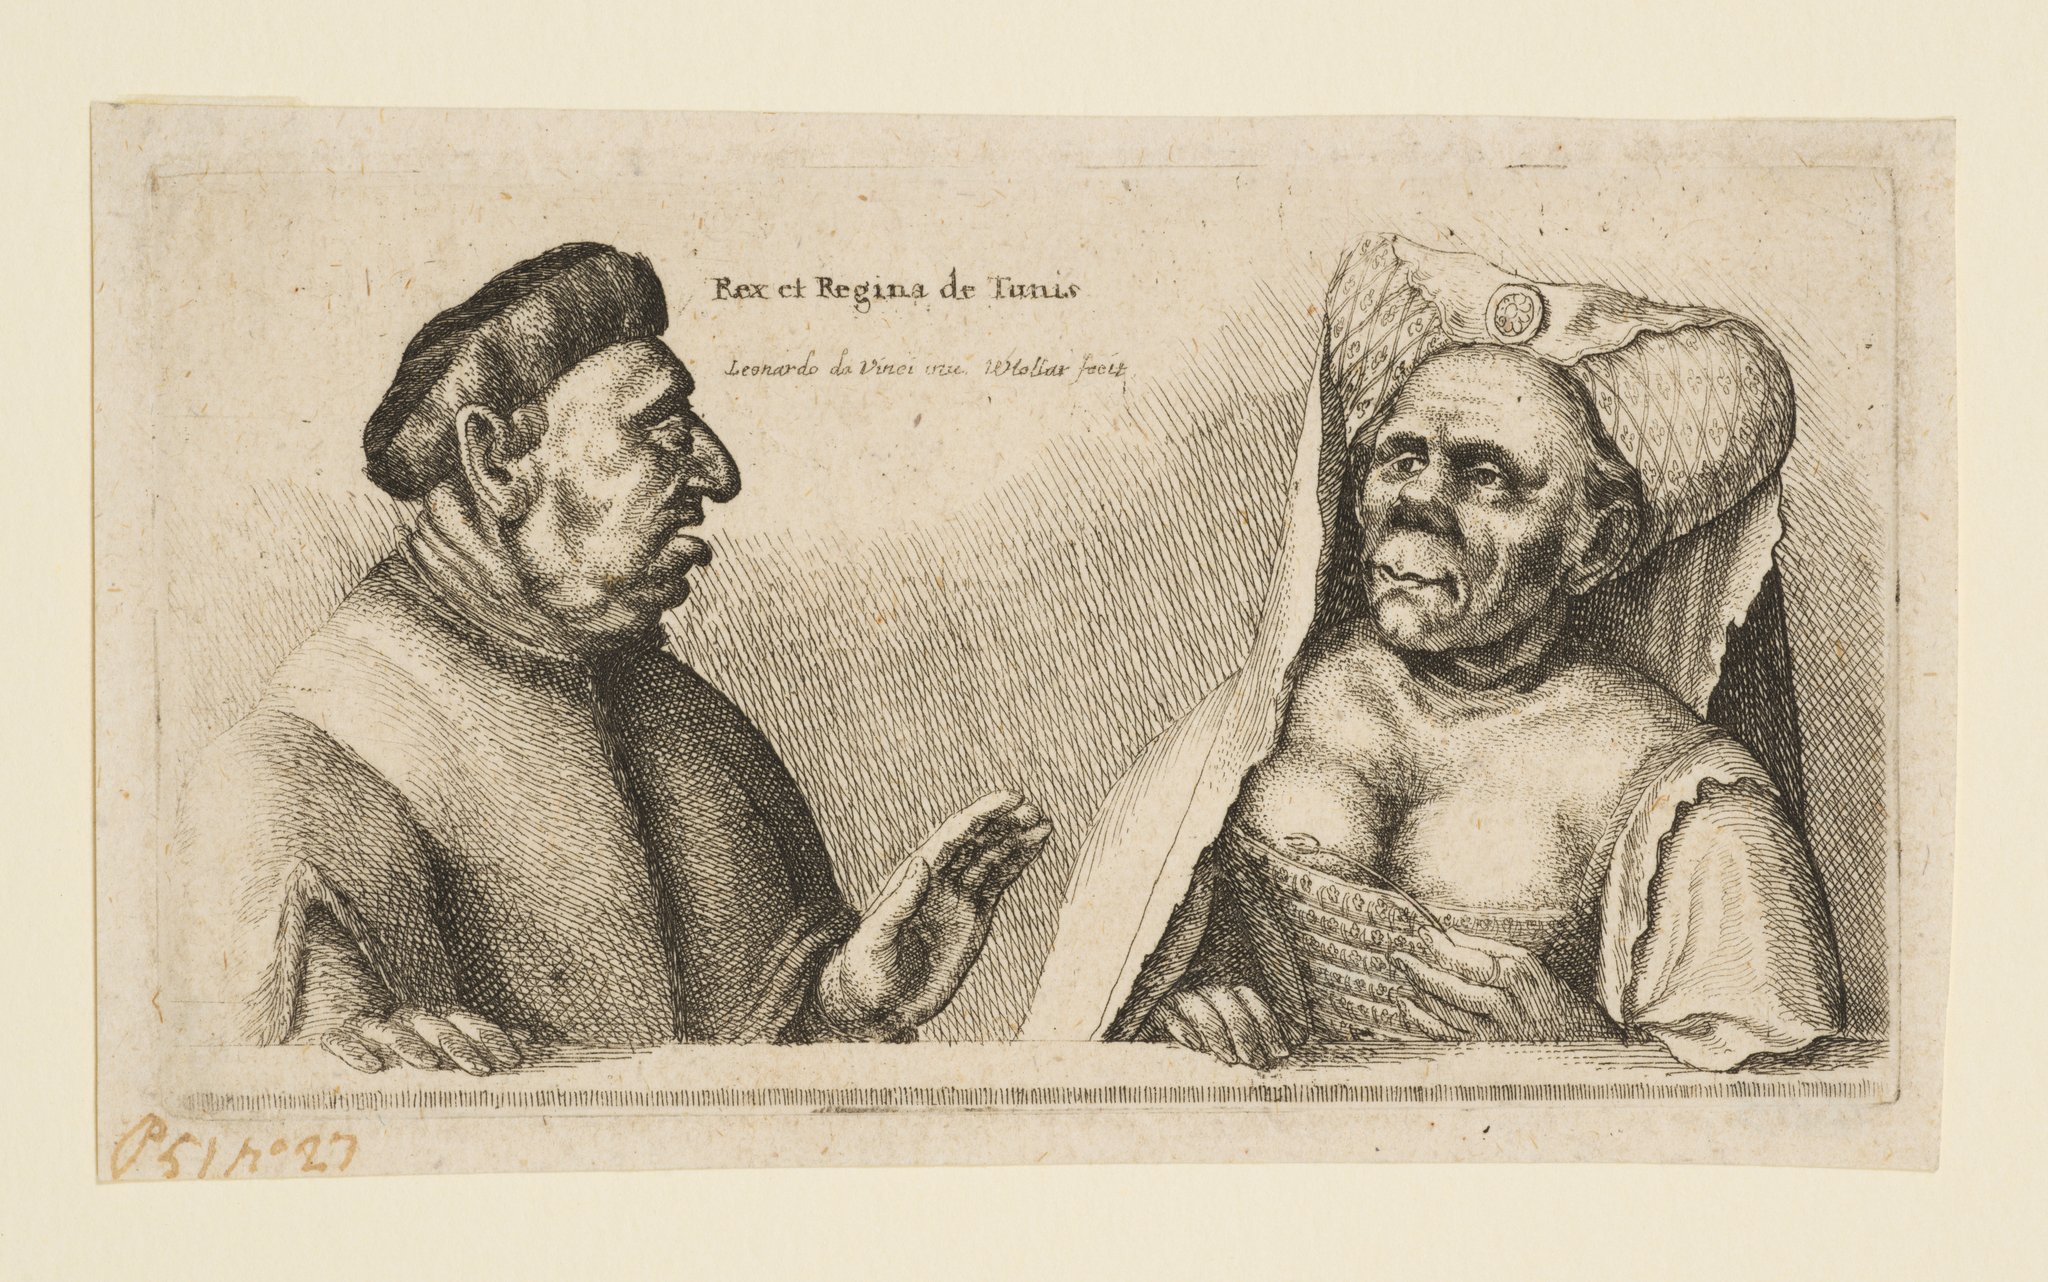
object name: print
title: The King and Queen of Tunis (Rex et Regina de Tunis)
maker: wenceslaus hollar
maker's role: artist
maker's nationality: bohemian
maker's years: 1607-1677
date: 1645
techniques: etching